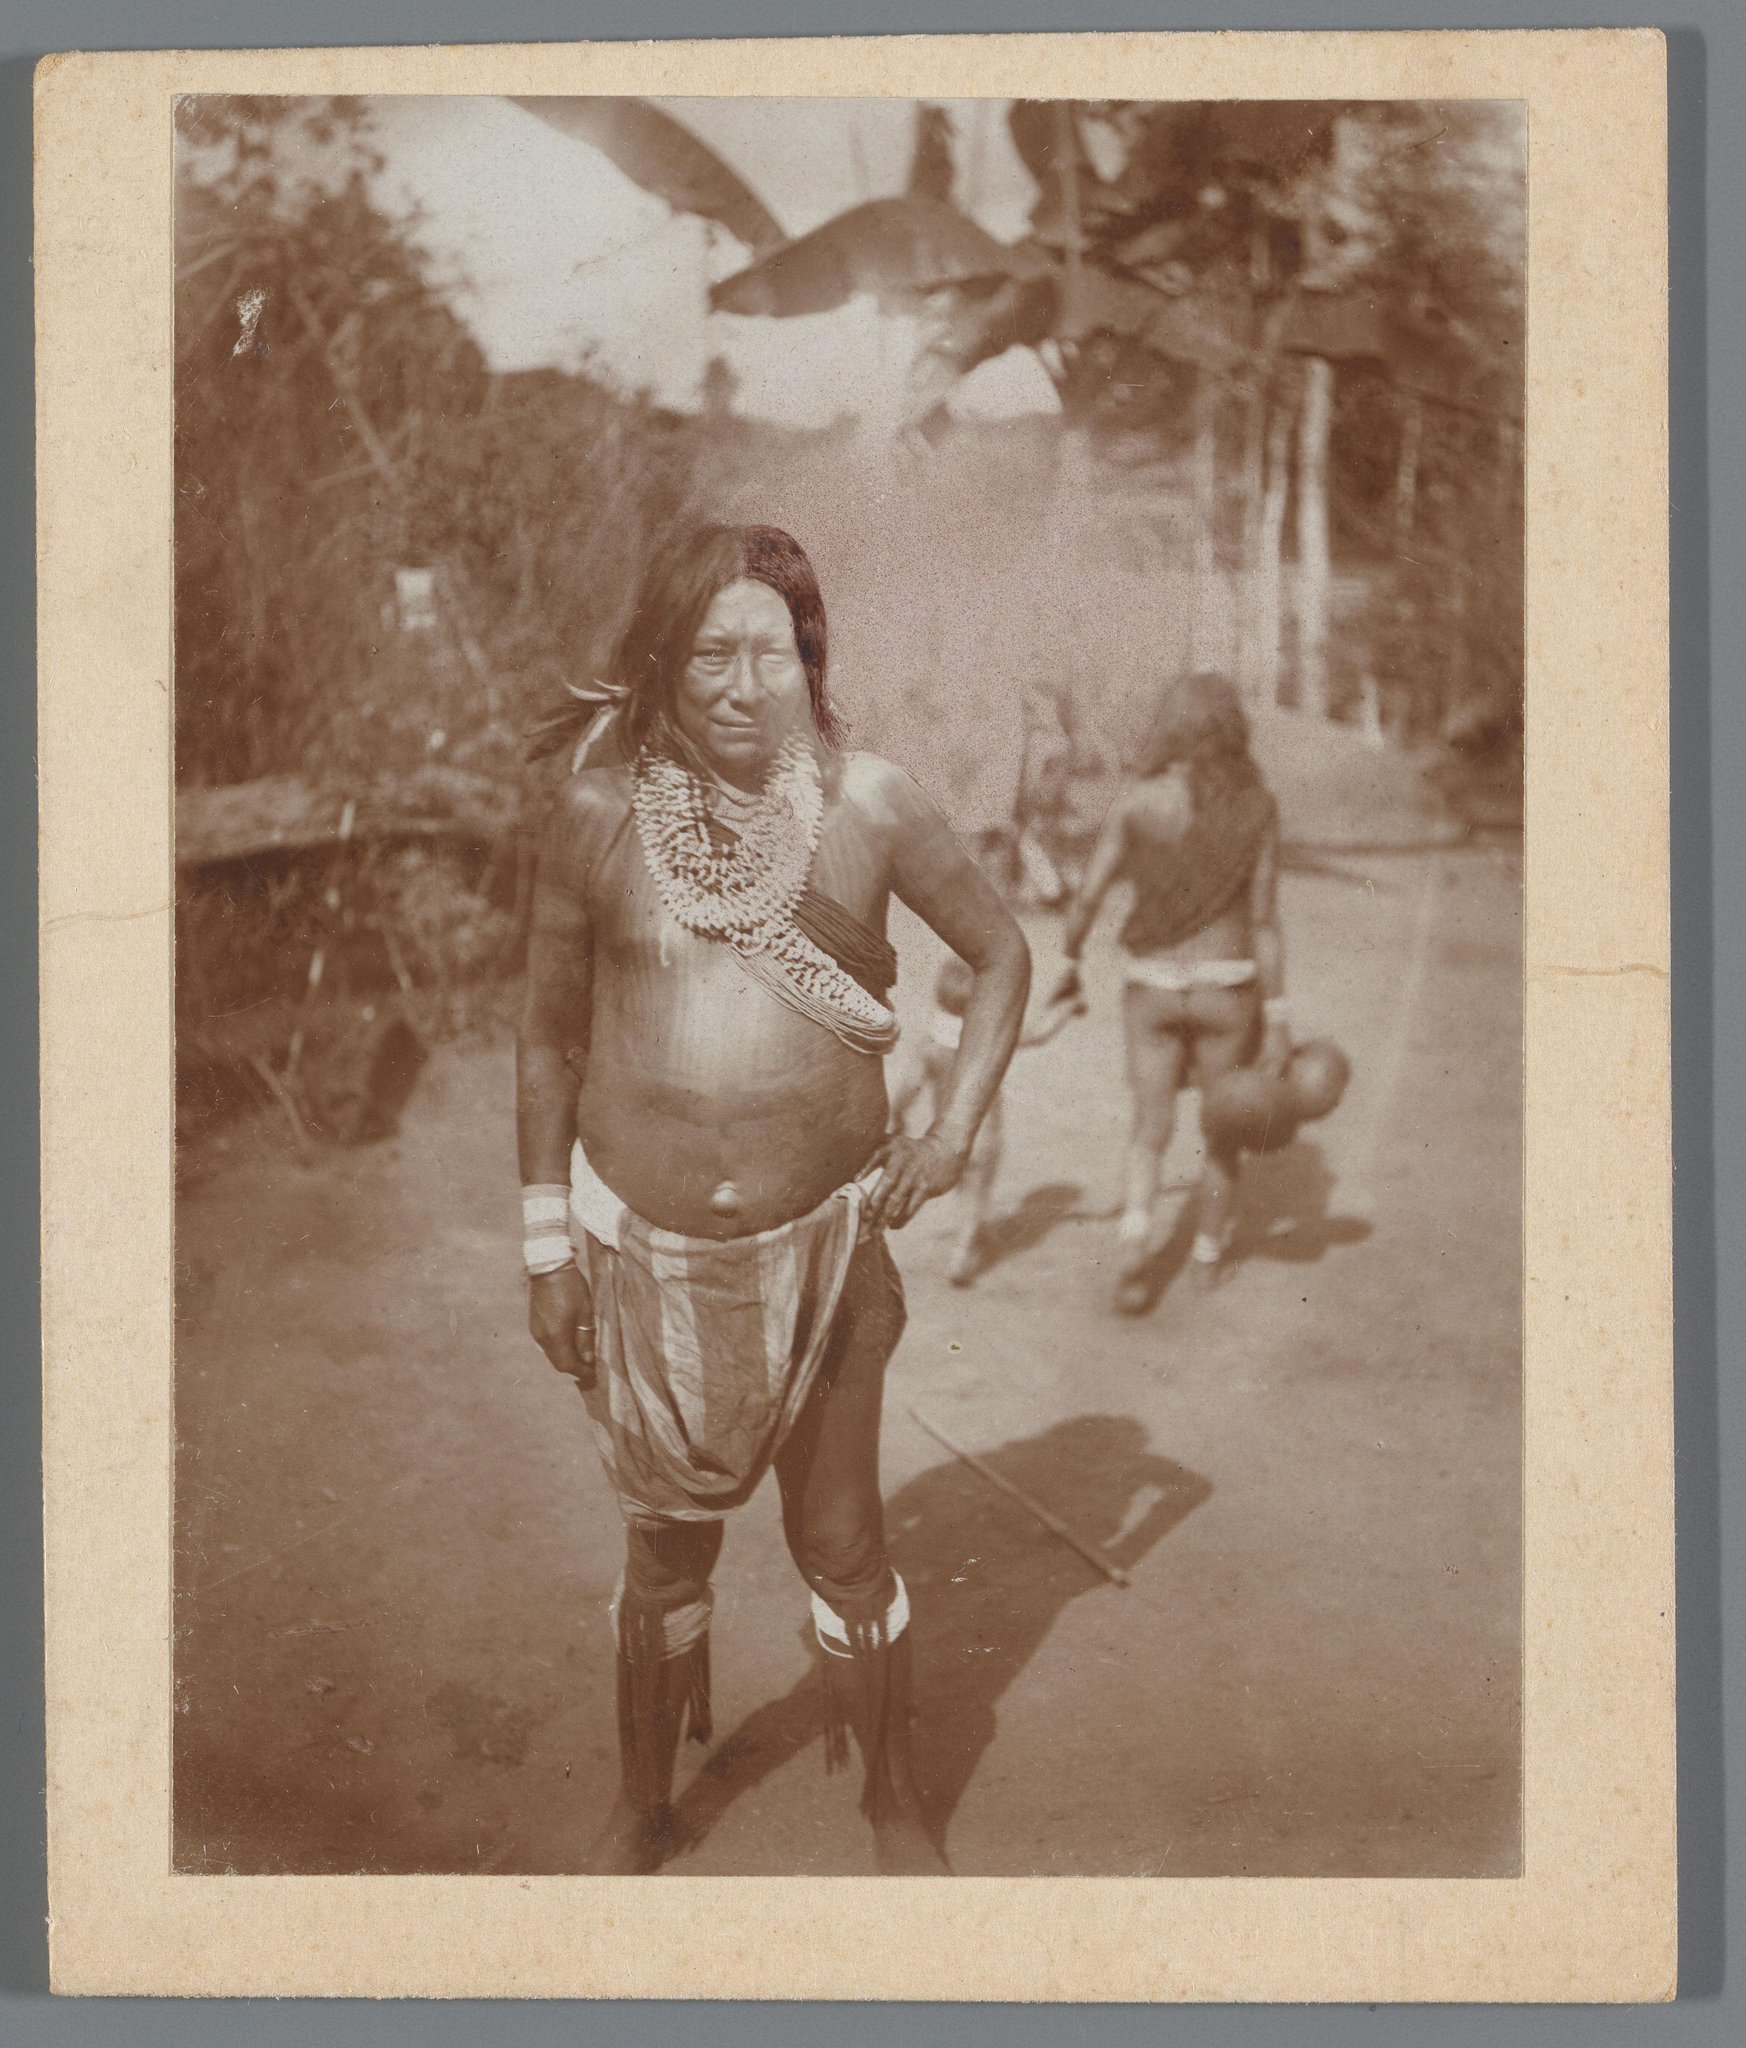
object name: photograph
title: Portret van een bewoner van het gebied rond de Tapanahoni-rivier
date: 1904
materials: cardboard, photographic support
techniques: collodion silver print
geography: suriname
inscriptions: annotation: ‘Foto der Toemoek ....expeditie’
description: Krijger in volle tooi nabij de Tapanahoni-rivier in Suriname ten tijde van de Toemoek-expeditie of Tapanahoni-expeditie die werd geinitieerd, onder andere door het Koninklijk Nederlands Aardrijkskundig Genootschap